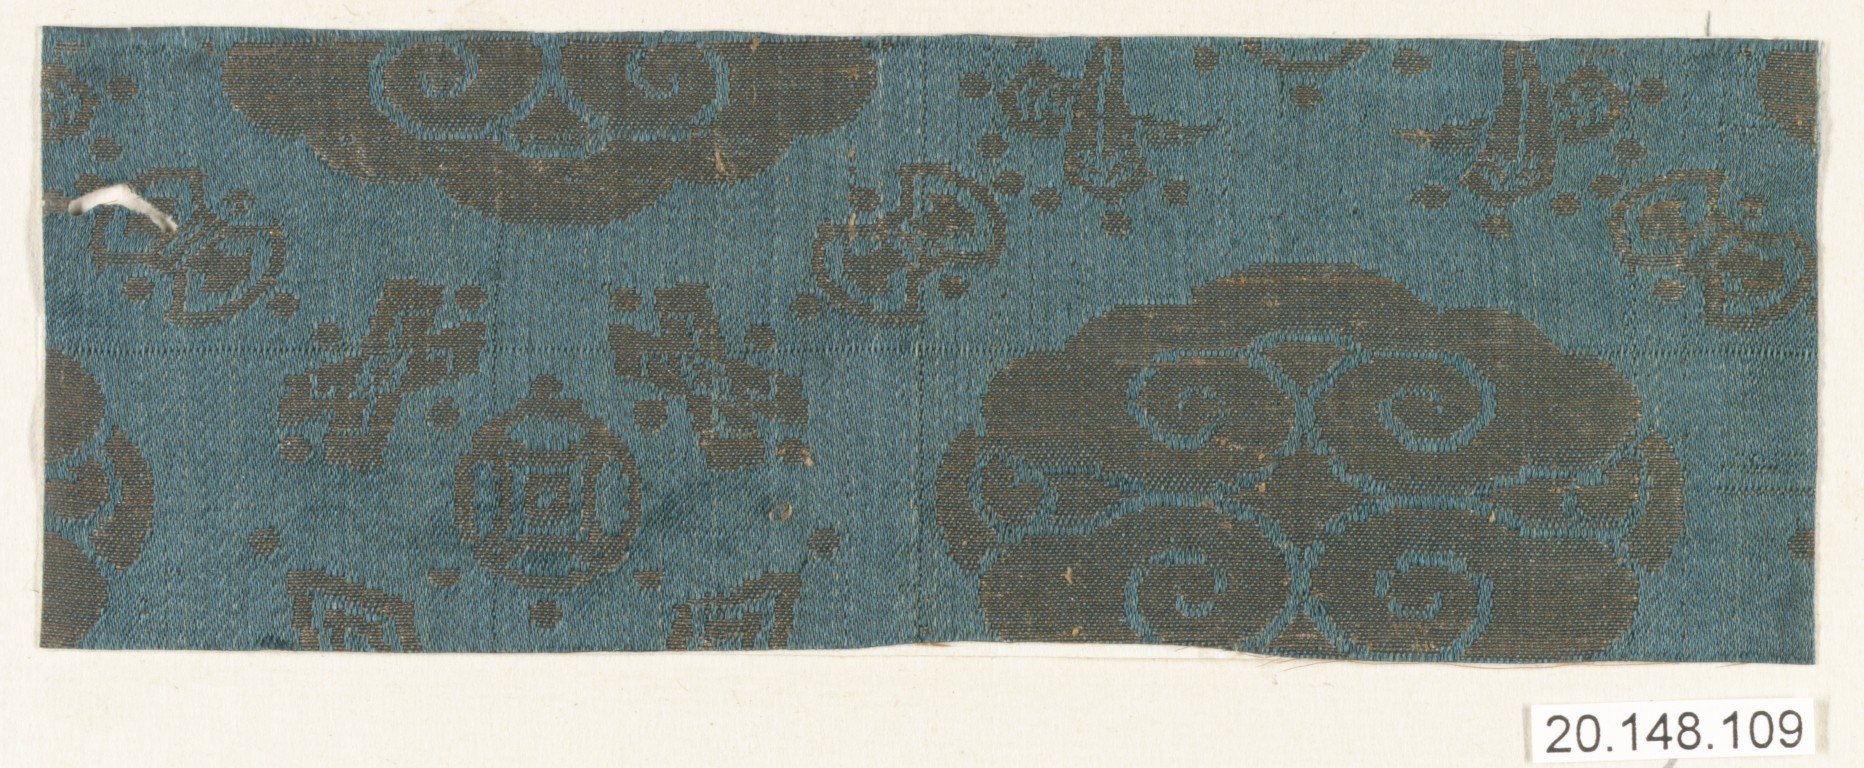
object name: piece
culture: japanese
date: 1601-1700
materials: silk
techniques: compound weave